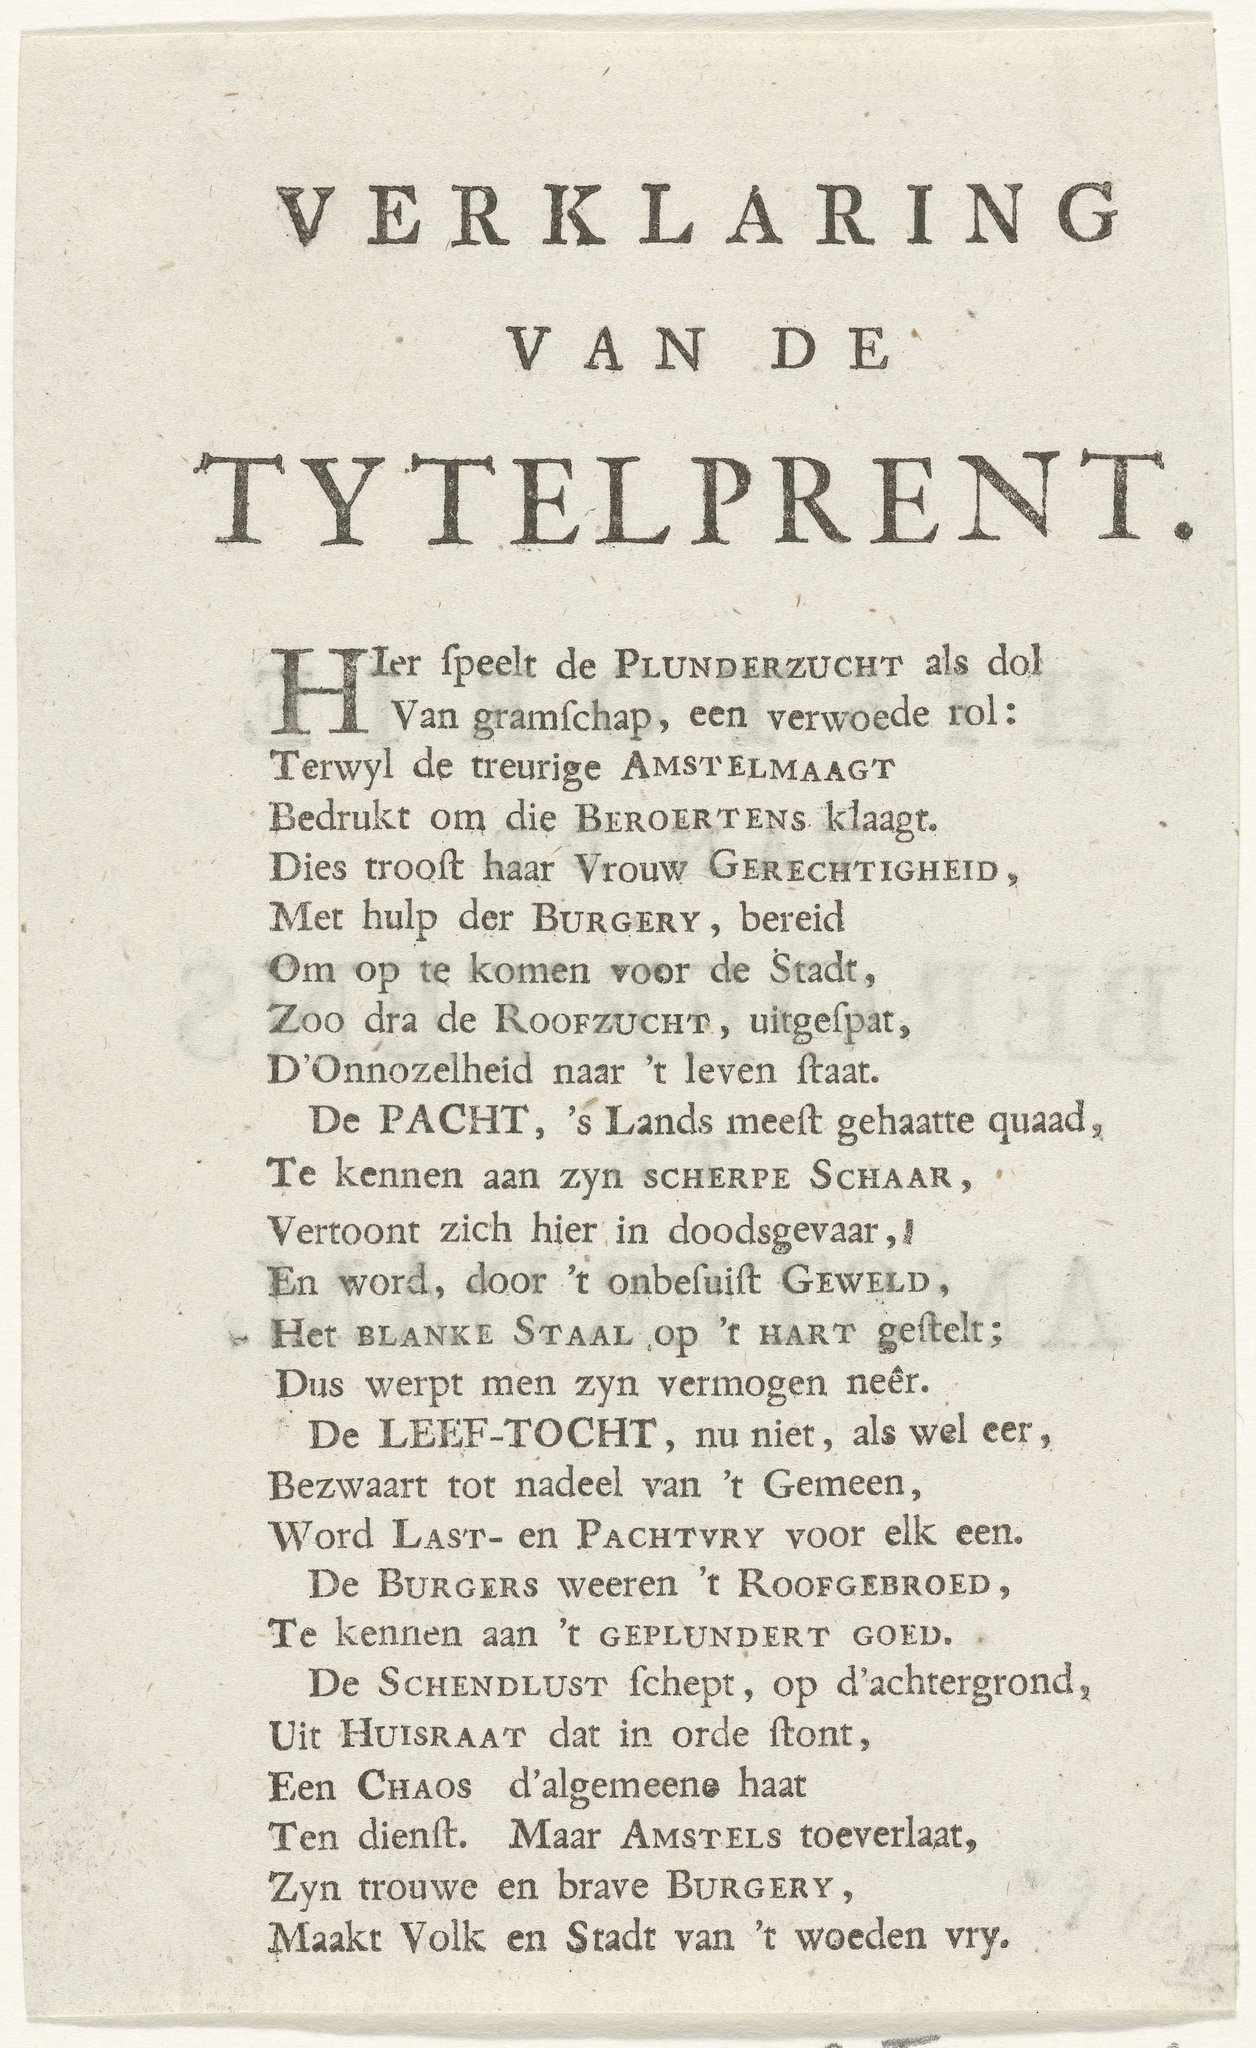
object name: text sheet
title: Verklaring van de prent op het titelblad van: Beknopte historie der beroertens te Amsterdam, 1748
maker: willem brinkink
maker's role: publisher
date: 1748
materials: paper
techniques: letterpress printing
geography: harderwijk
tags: amsterdam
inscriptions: collector's mark: Lugt 2228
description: Tekstblad met de verklaring in versvorm van de prent op het titelblad van het boekje: Beknopte historie der beroertens te Amsterdam uit 1748. Op de achterzijde de titel: Historie van de beroertens te Amsterdam.